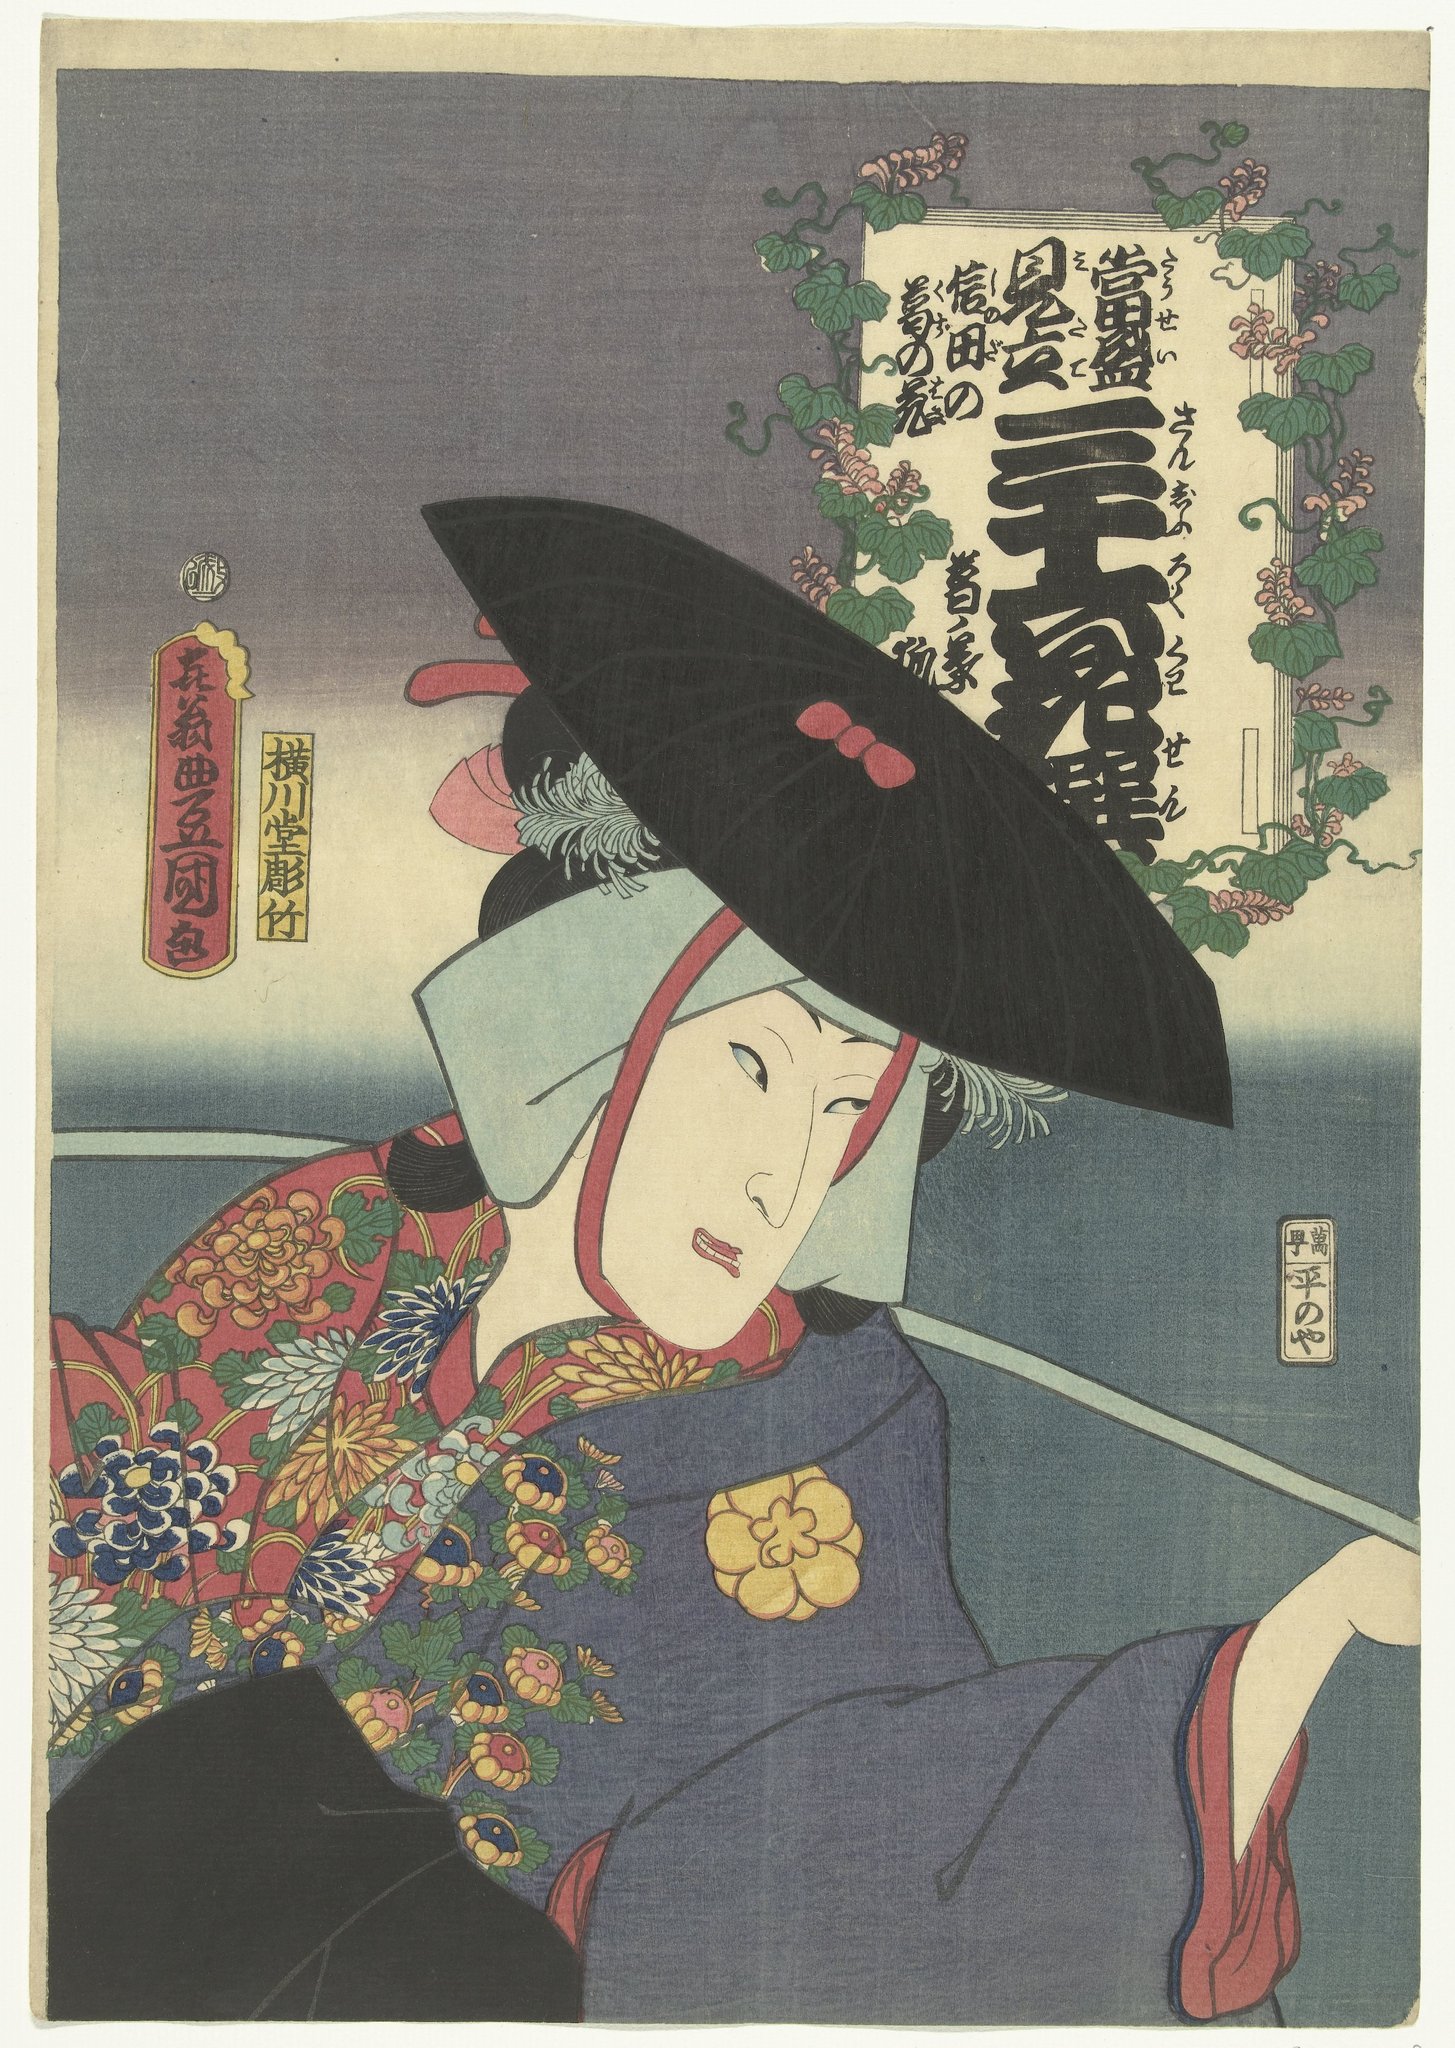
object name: print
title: Contemporaine verwijzingen naar de 36 dichters.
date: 1802-1862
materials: paper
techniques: woodcut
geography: japan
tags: actor (on the stage)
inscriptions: date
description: Busteportret van de acteur Nakamura Shikan IV in de vrouwenrol Kuzunoha in paars en rode kimono met bloemmotief en zwart hoofddeksel; tegen paars, wit en blauwe achtergrond.